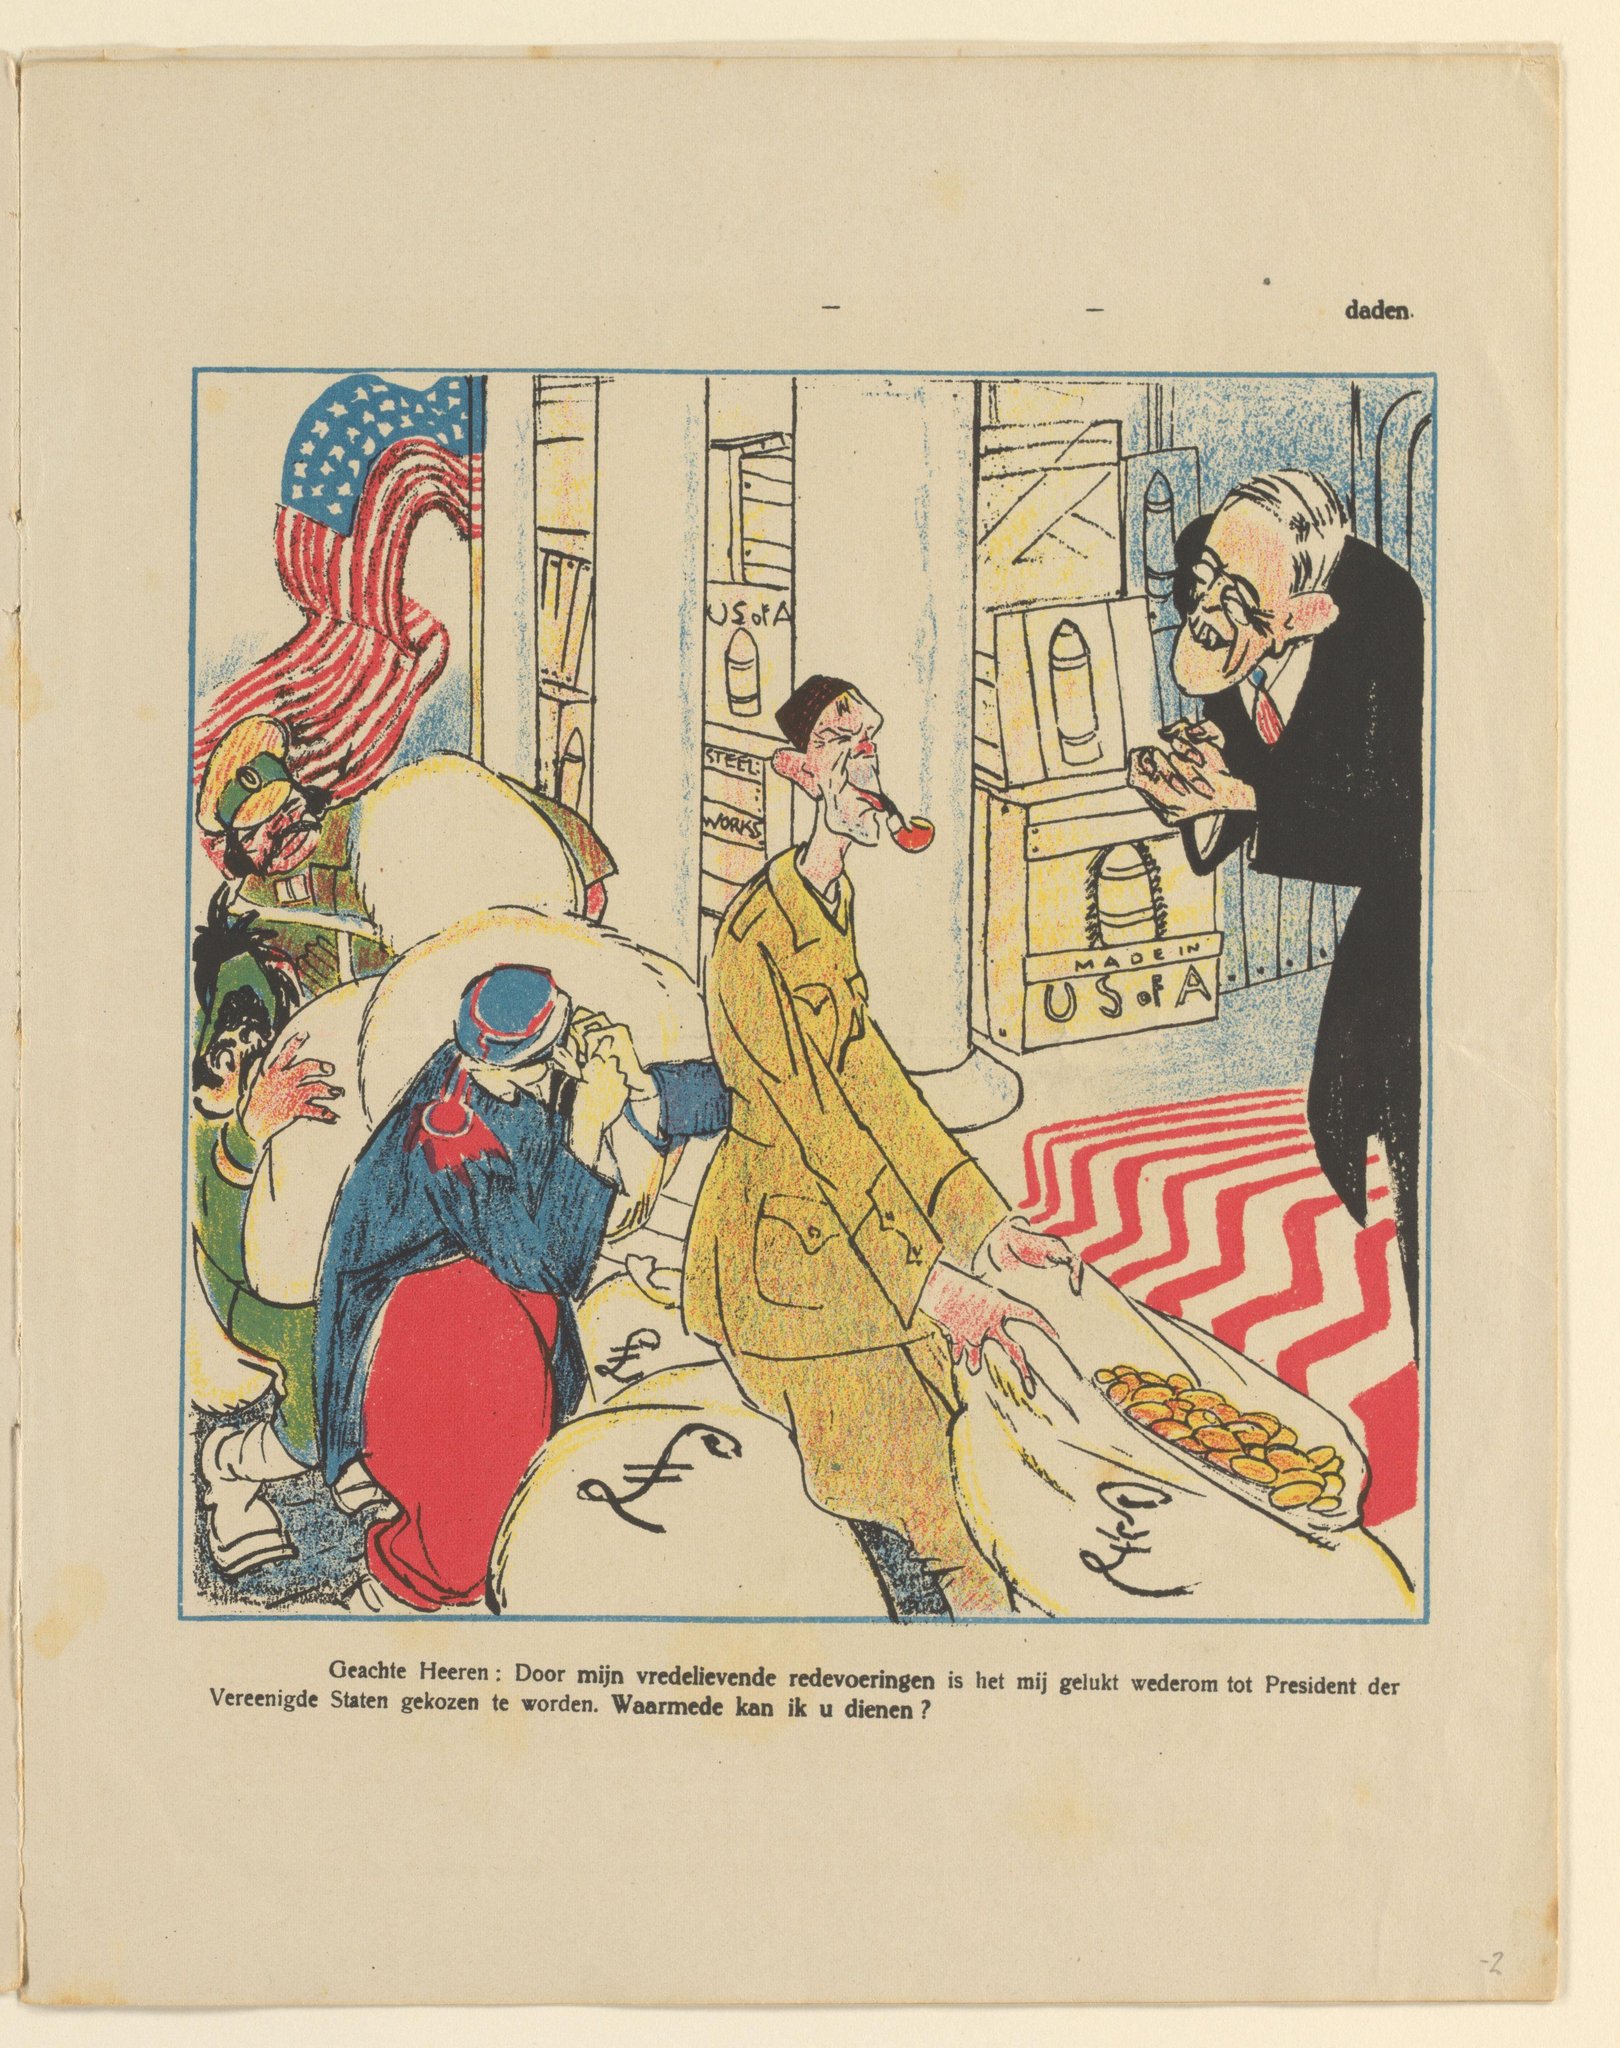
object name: book illustration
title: Woodrow Wilson ontvangt zakken geld van diverse landen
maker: Anonymous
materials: paper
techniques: lithograph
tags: war and peace, political caricatures and satires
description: Prent uit: Bluff. Woorden en daden van Woodrow Wilson president der Vereenigde Staten van Amerika. S.l., s.n., [ca. 1917].